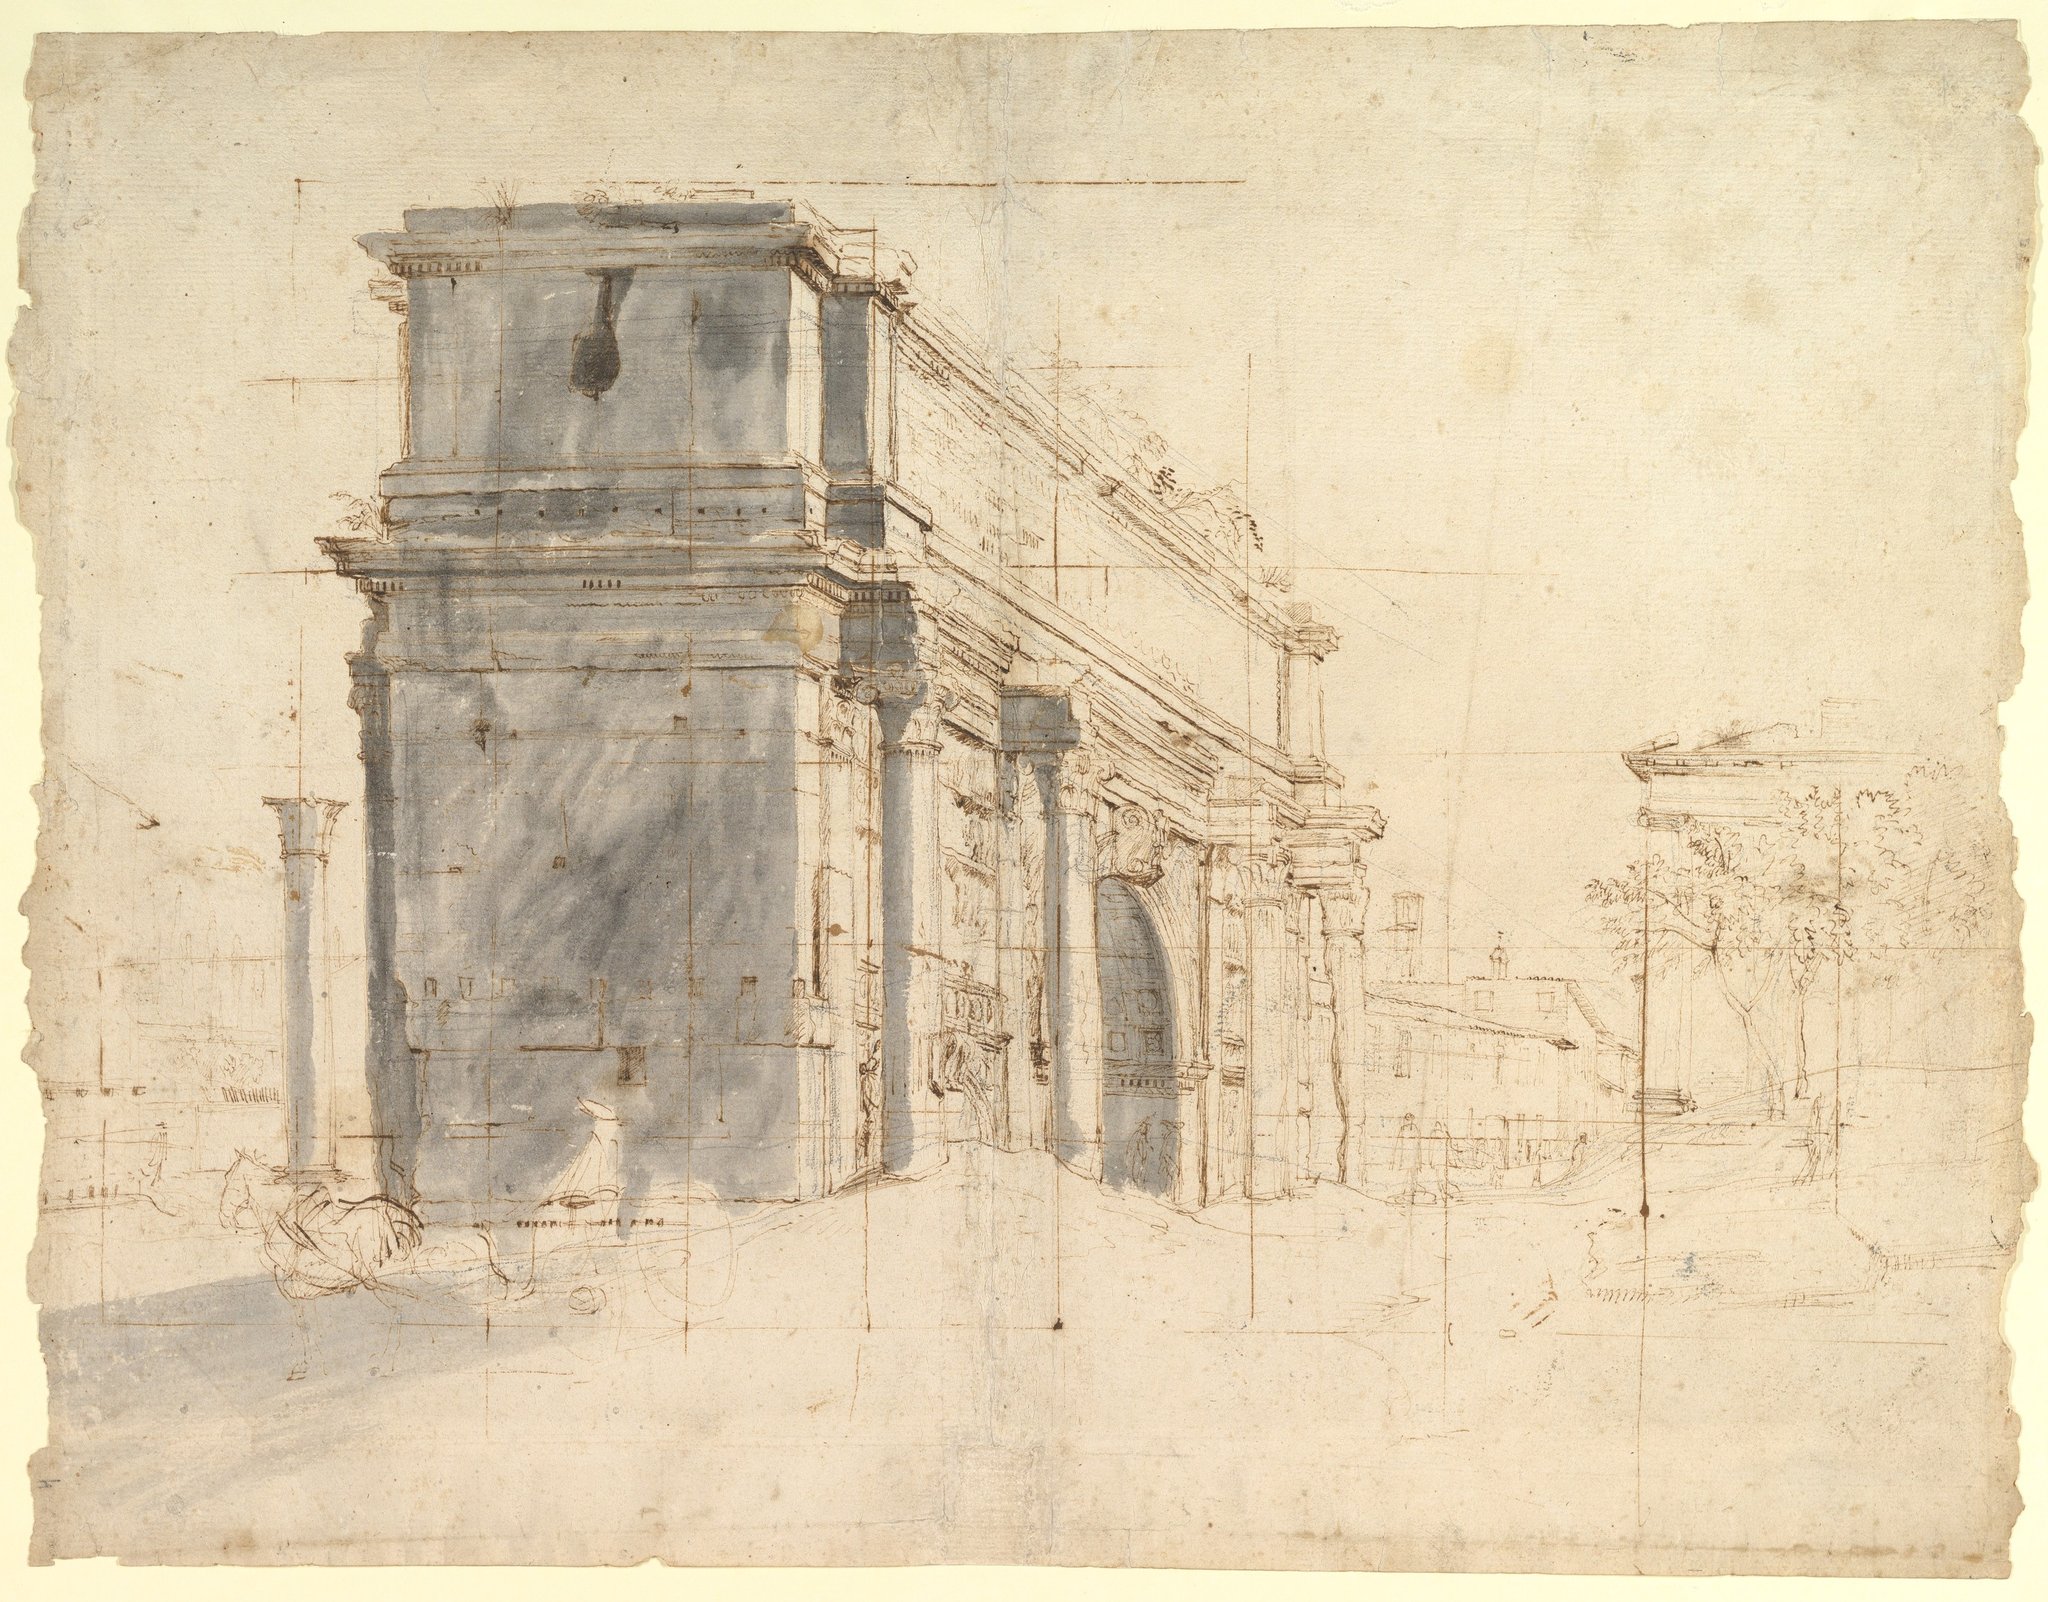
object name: drawing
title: The Arch of Septimius Severus in the Roman Forum, with the Column of Phocas at the Left and the Temple of Saturn at the Right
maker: gaspar adriaensz. van wittel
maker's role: artist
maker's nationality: dutch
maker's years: 1652-1736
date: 1634-1766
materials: ink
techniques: brush, pen, drawing, transfer, wash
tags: arches